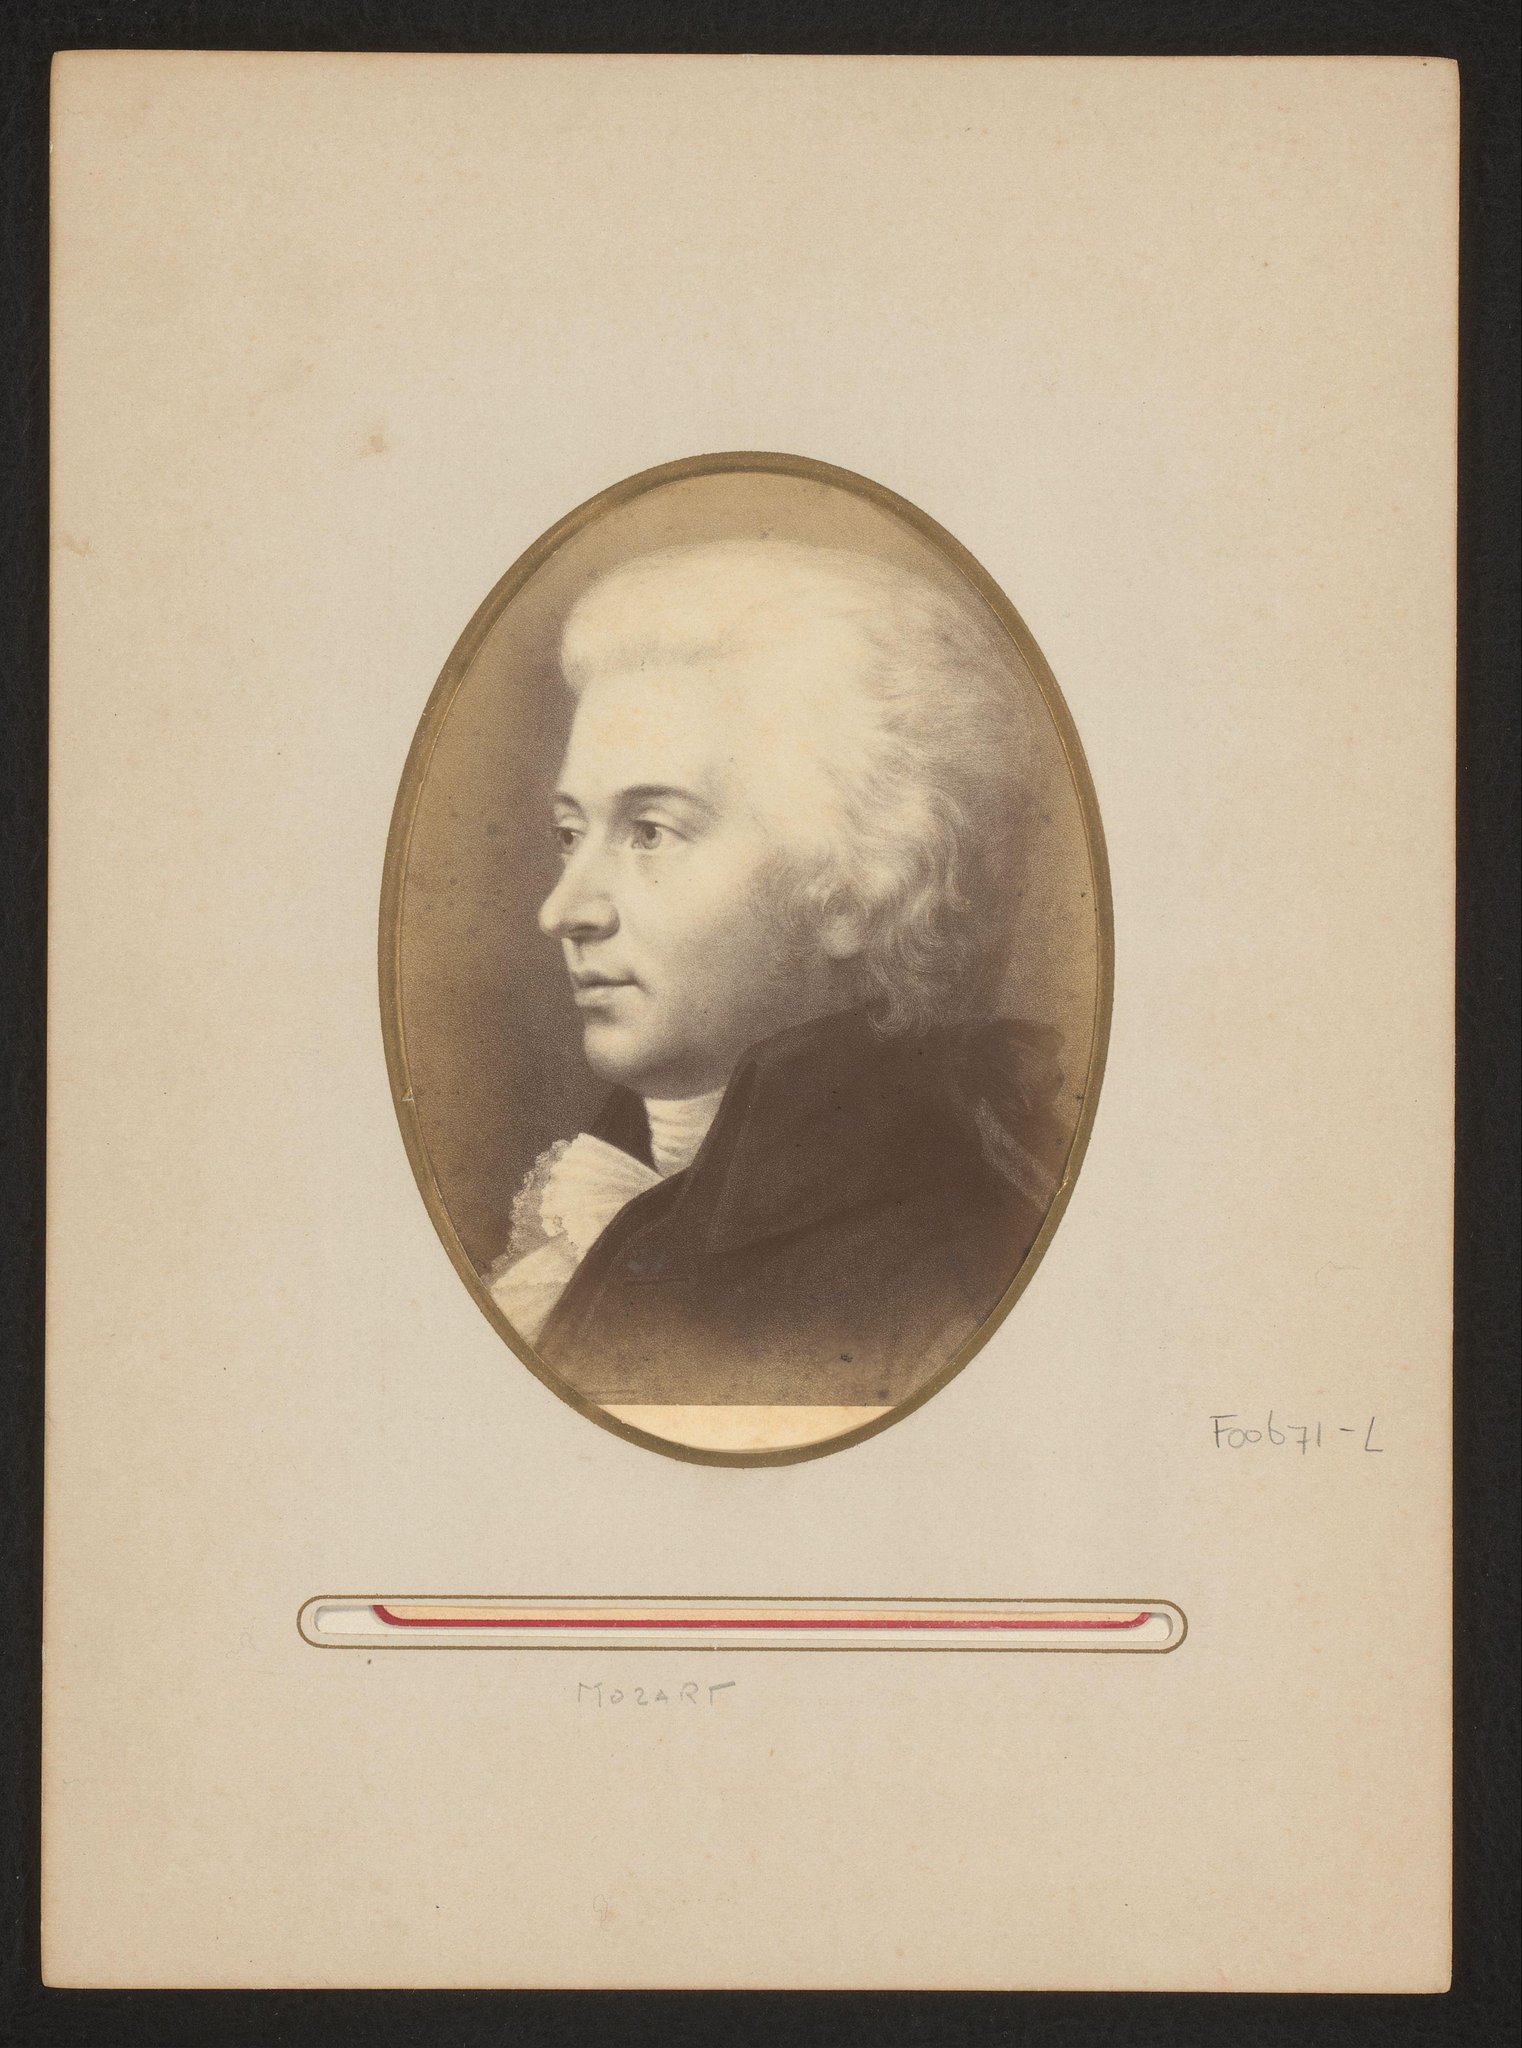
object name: cabinet photograph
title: Fotoreproductie van een getekend portret van Wolfgang Amadeus Mozart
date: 1870-1900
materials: cardboard, photographic support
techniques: albumen print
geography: berlin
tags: historical persons, portrait of composer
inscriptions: name: ‘W. A. Mozart’, inscription: ‘Eigenthum und Verlag von/ E.H. Schroeder/ Hermann Kaiser/ Berlin/ 41. Unter den Linden 41./ Phot. G. Schauer./ Berlin./ Typ. G Lange (O. Lange)’